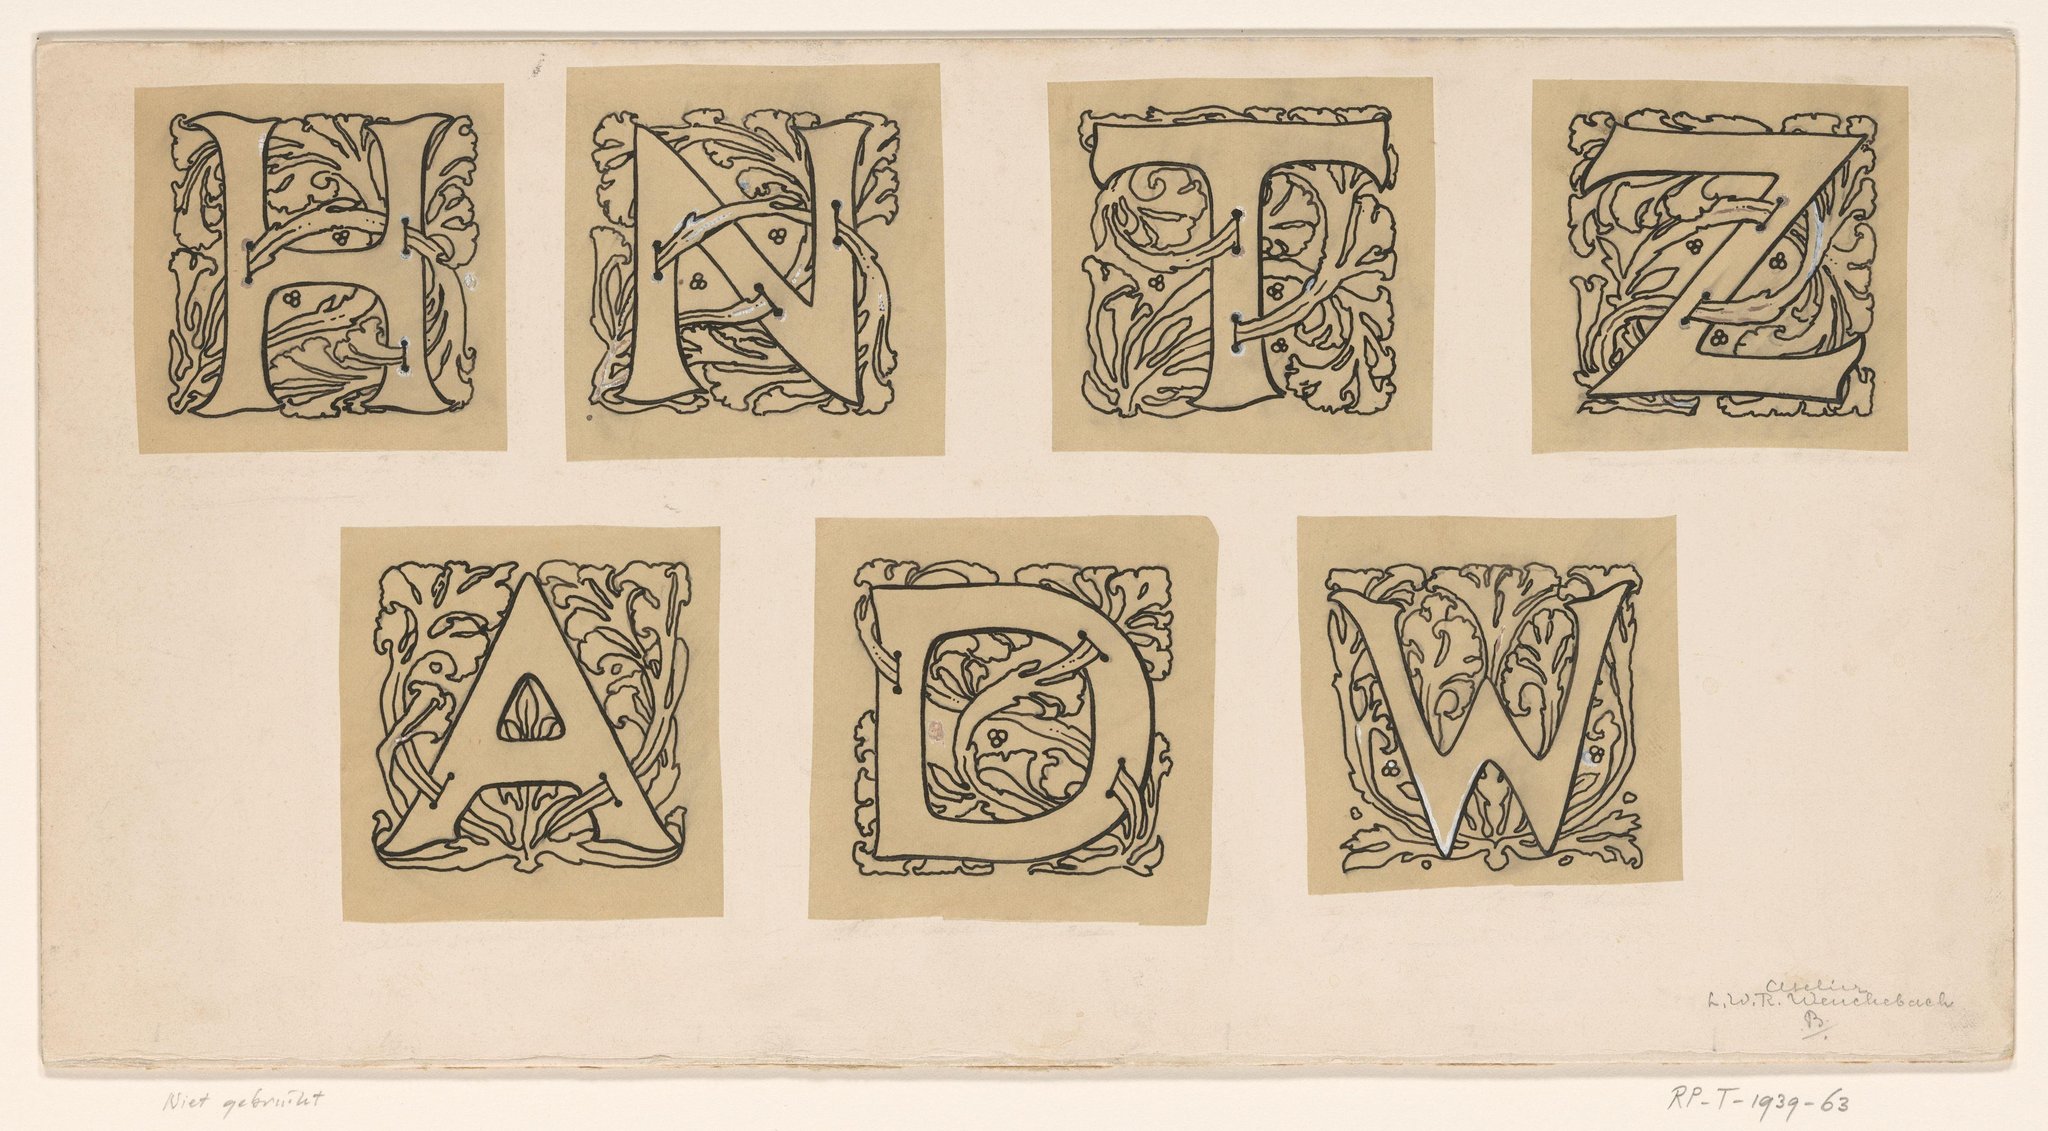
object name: design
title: Ontwerp voor versierde initialen H, N, T, Z, A, D en W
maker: willem wenckebach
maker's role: designer, draughtsman, painter, print maker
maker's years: 1860-1937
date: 1898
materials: cardboard, paint, ink, pencil, paper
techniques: brush, pen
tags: initial, foliage, tendrils, branches ~ ornament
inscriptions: collector's mark: Lugt 2228a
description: Ontwerp voor zeven initialen versierd met bladmotieven.